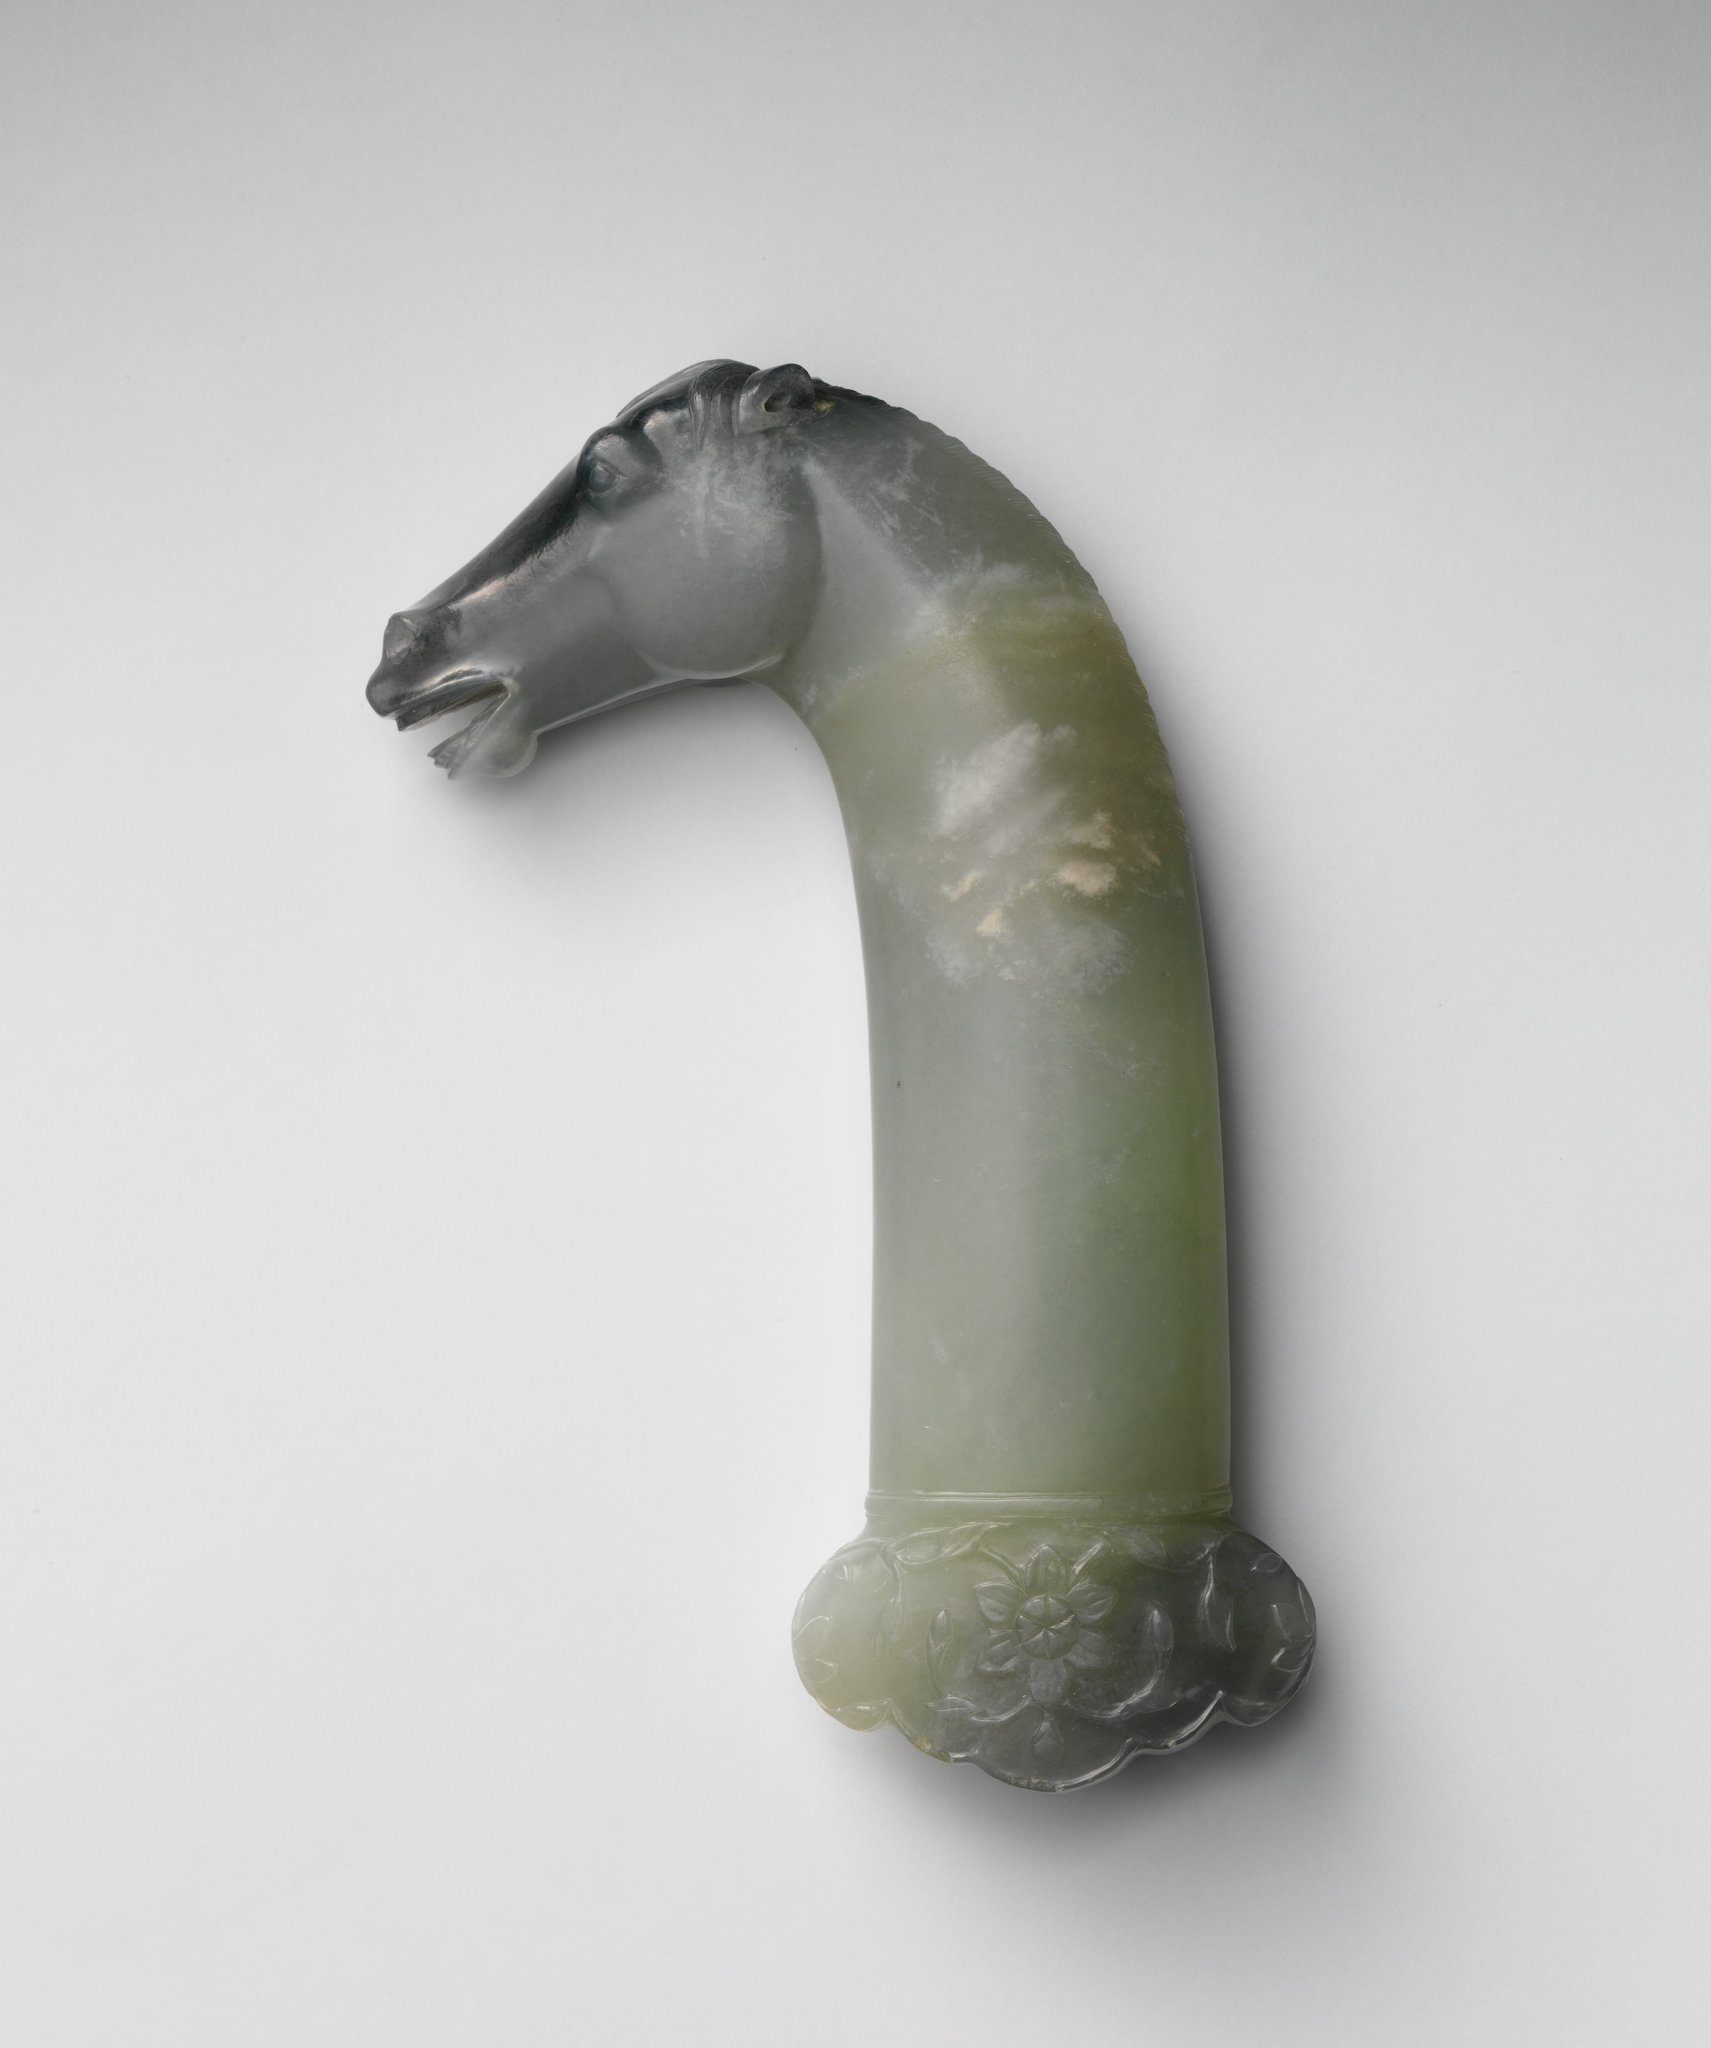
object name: dagger hilt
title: Hilt of a Dagger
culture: indian, mughal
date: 1667-1733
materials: jade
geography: india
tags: horses